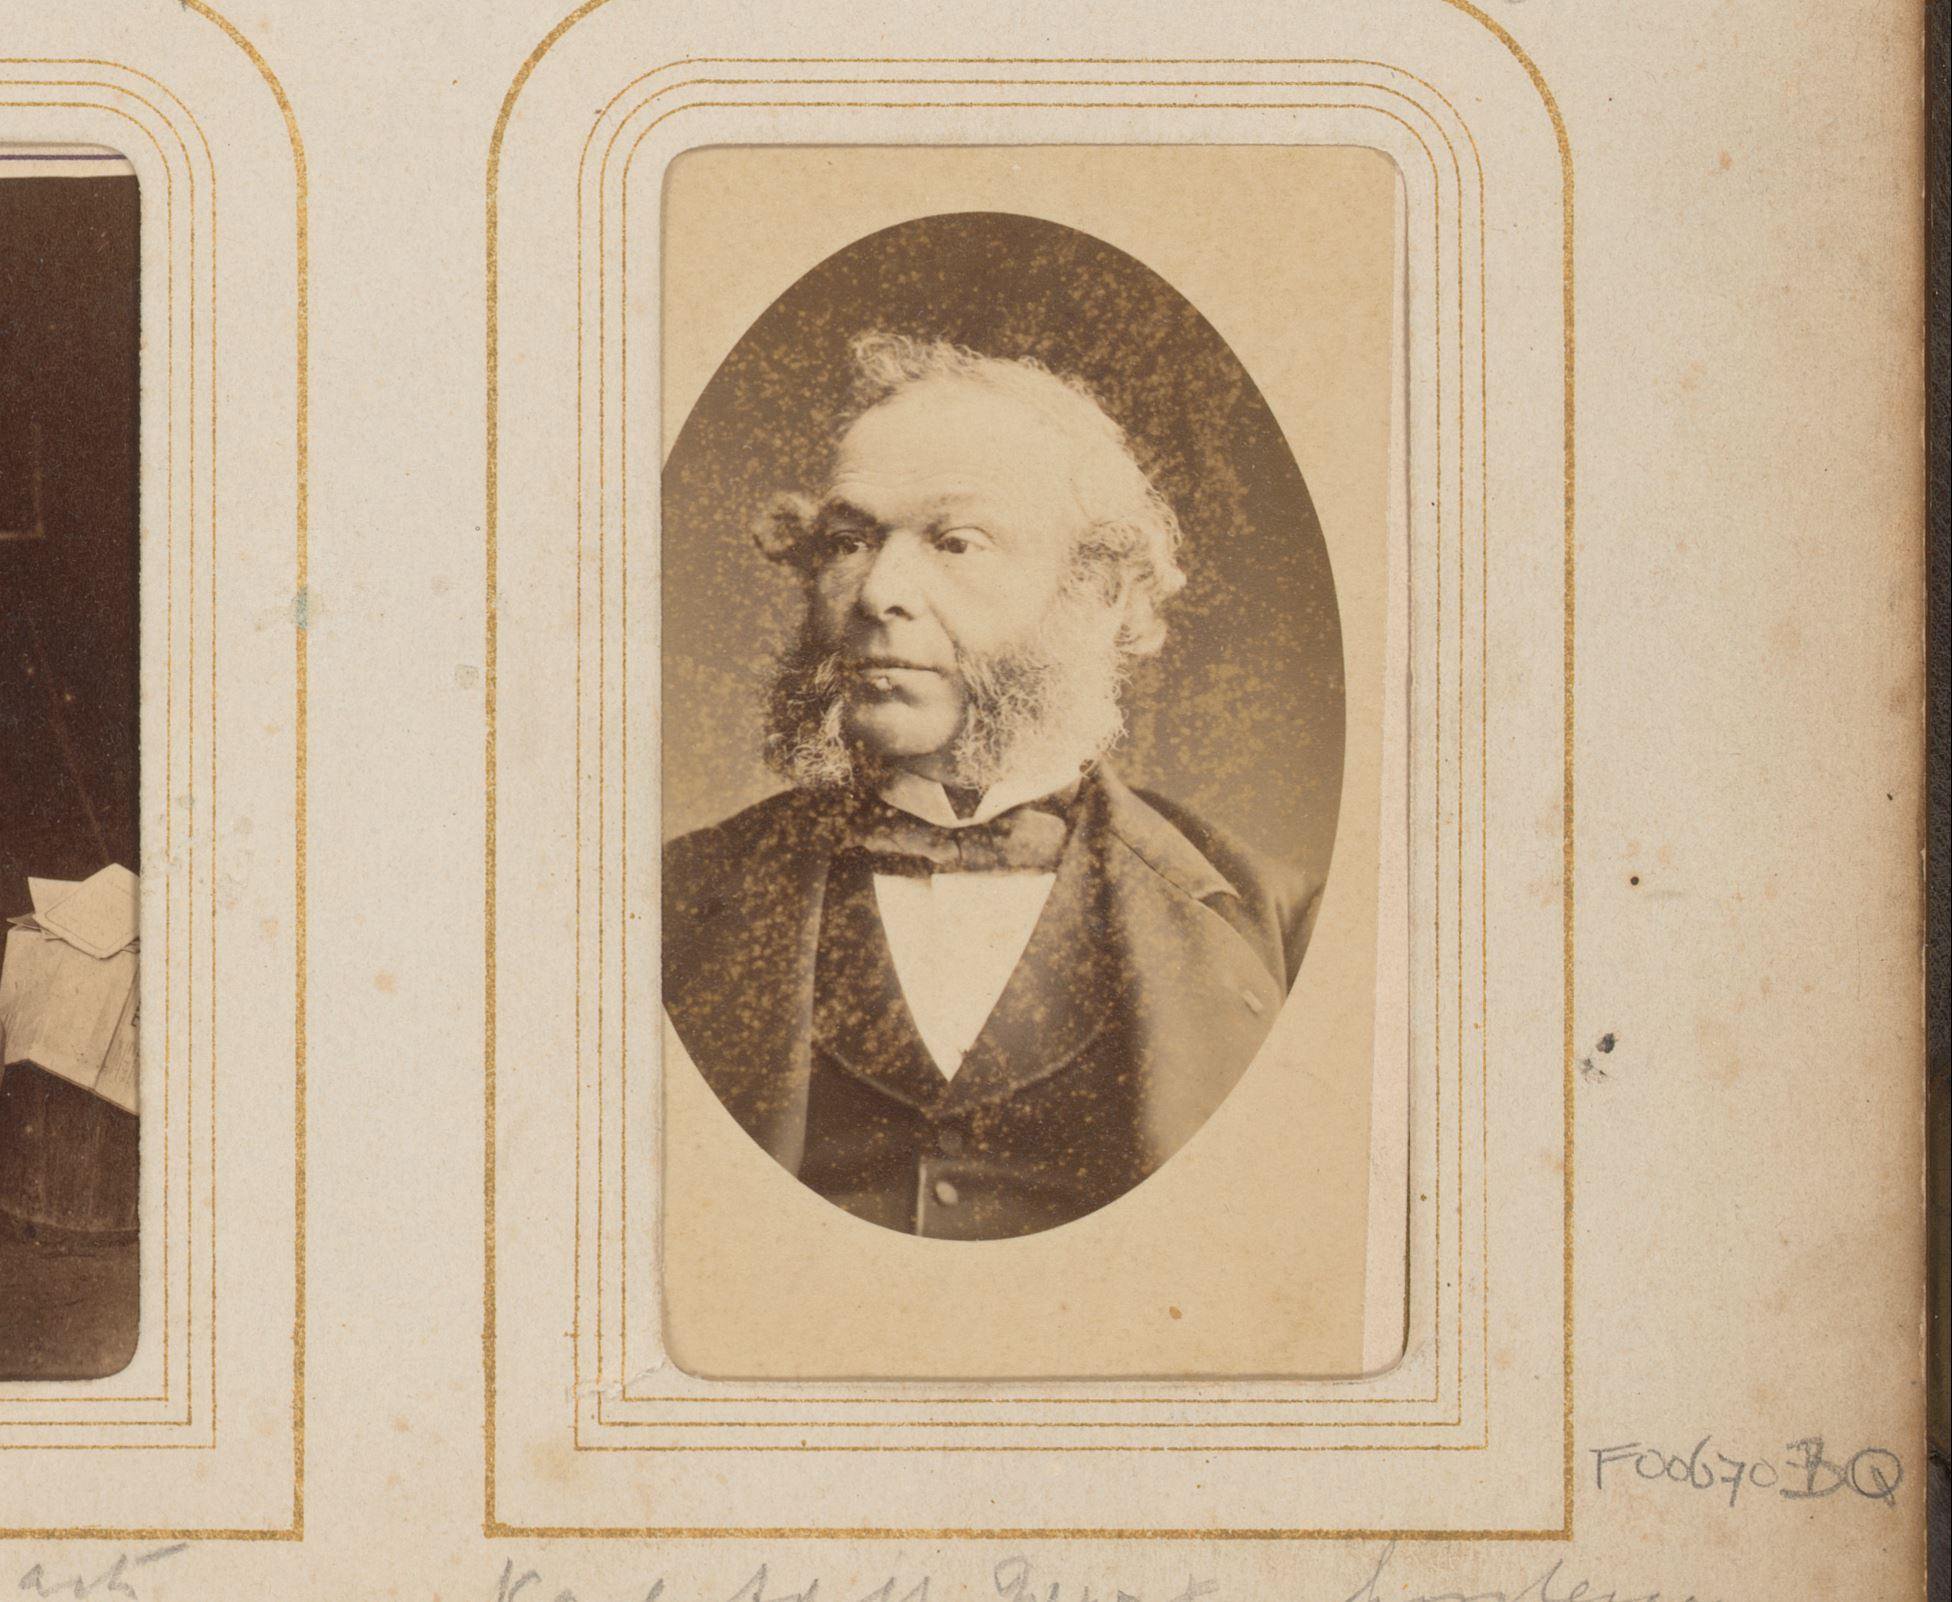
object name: album leaf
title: Portret van Charles-Adolphe Wurtz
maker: a. griveau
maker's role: fotograaf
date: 1860-1880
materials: cardboard, photographic support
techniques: albumen print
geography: paris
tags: paris, historical persons, professor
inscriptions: annotation: ‘Karl Adolf Wurtz hoogleraar/ chemie en toxicologie Parijs/ 1817-1884/ (Griveau)’, inscription: ‘A. Griveau/ acquereur des Collections/ d'Anatole Pougnet/ edituer/ 42, Rue aux Ours./ Paris’, name: ‘Wurtz’